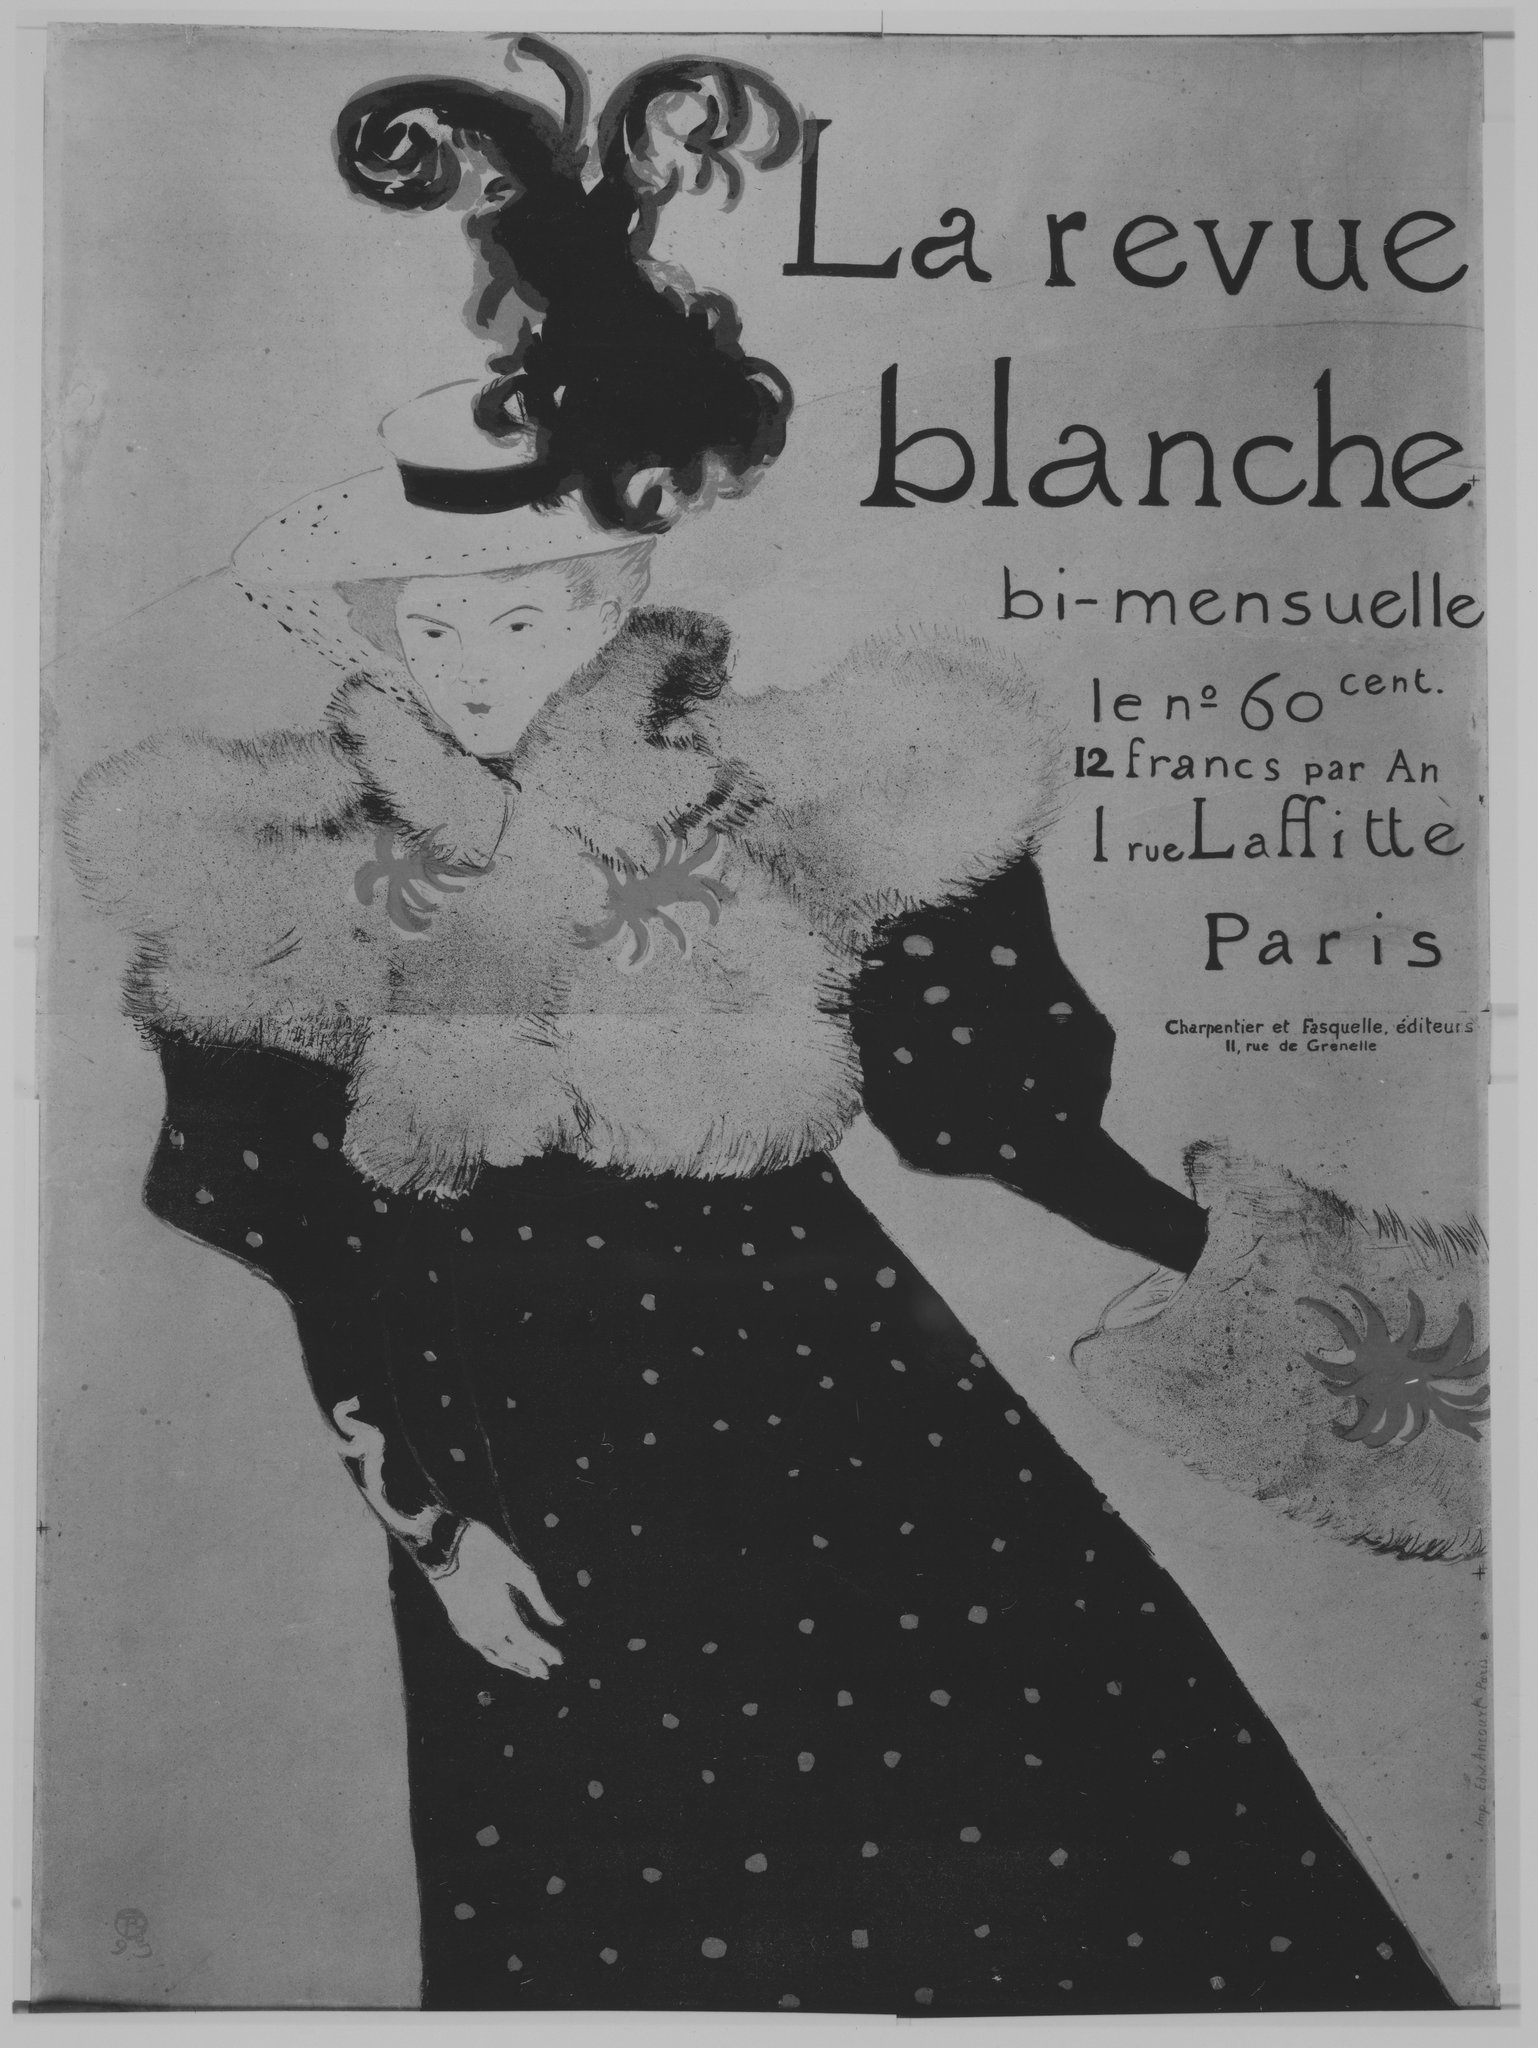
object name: print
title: La Revue Blanche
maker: henri de toulouse-lautrec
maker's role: artist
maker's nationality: french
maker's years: 1864-1901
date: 1895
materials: paper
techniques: lithograph, printing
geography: france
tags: women